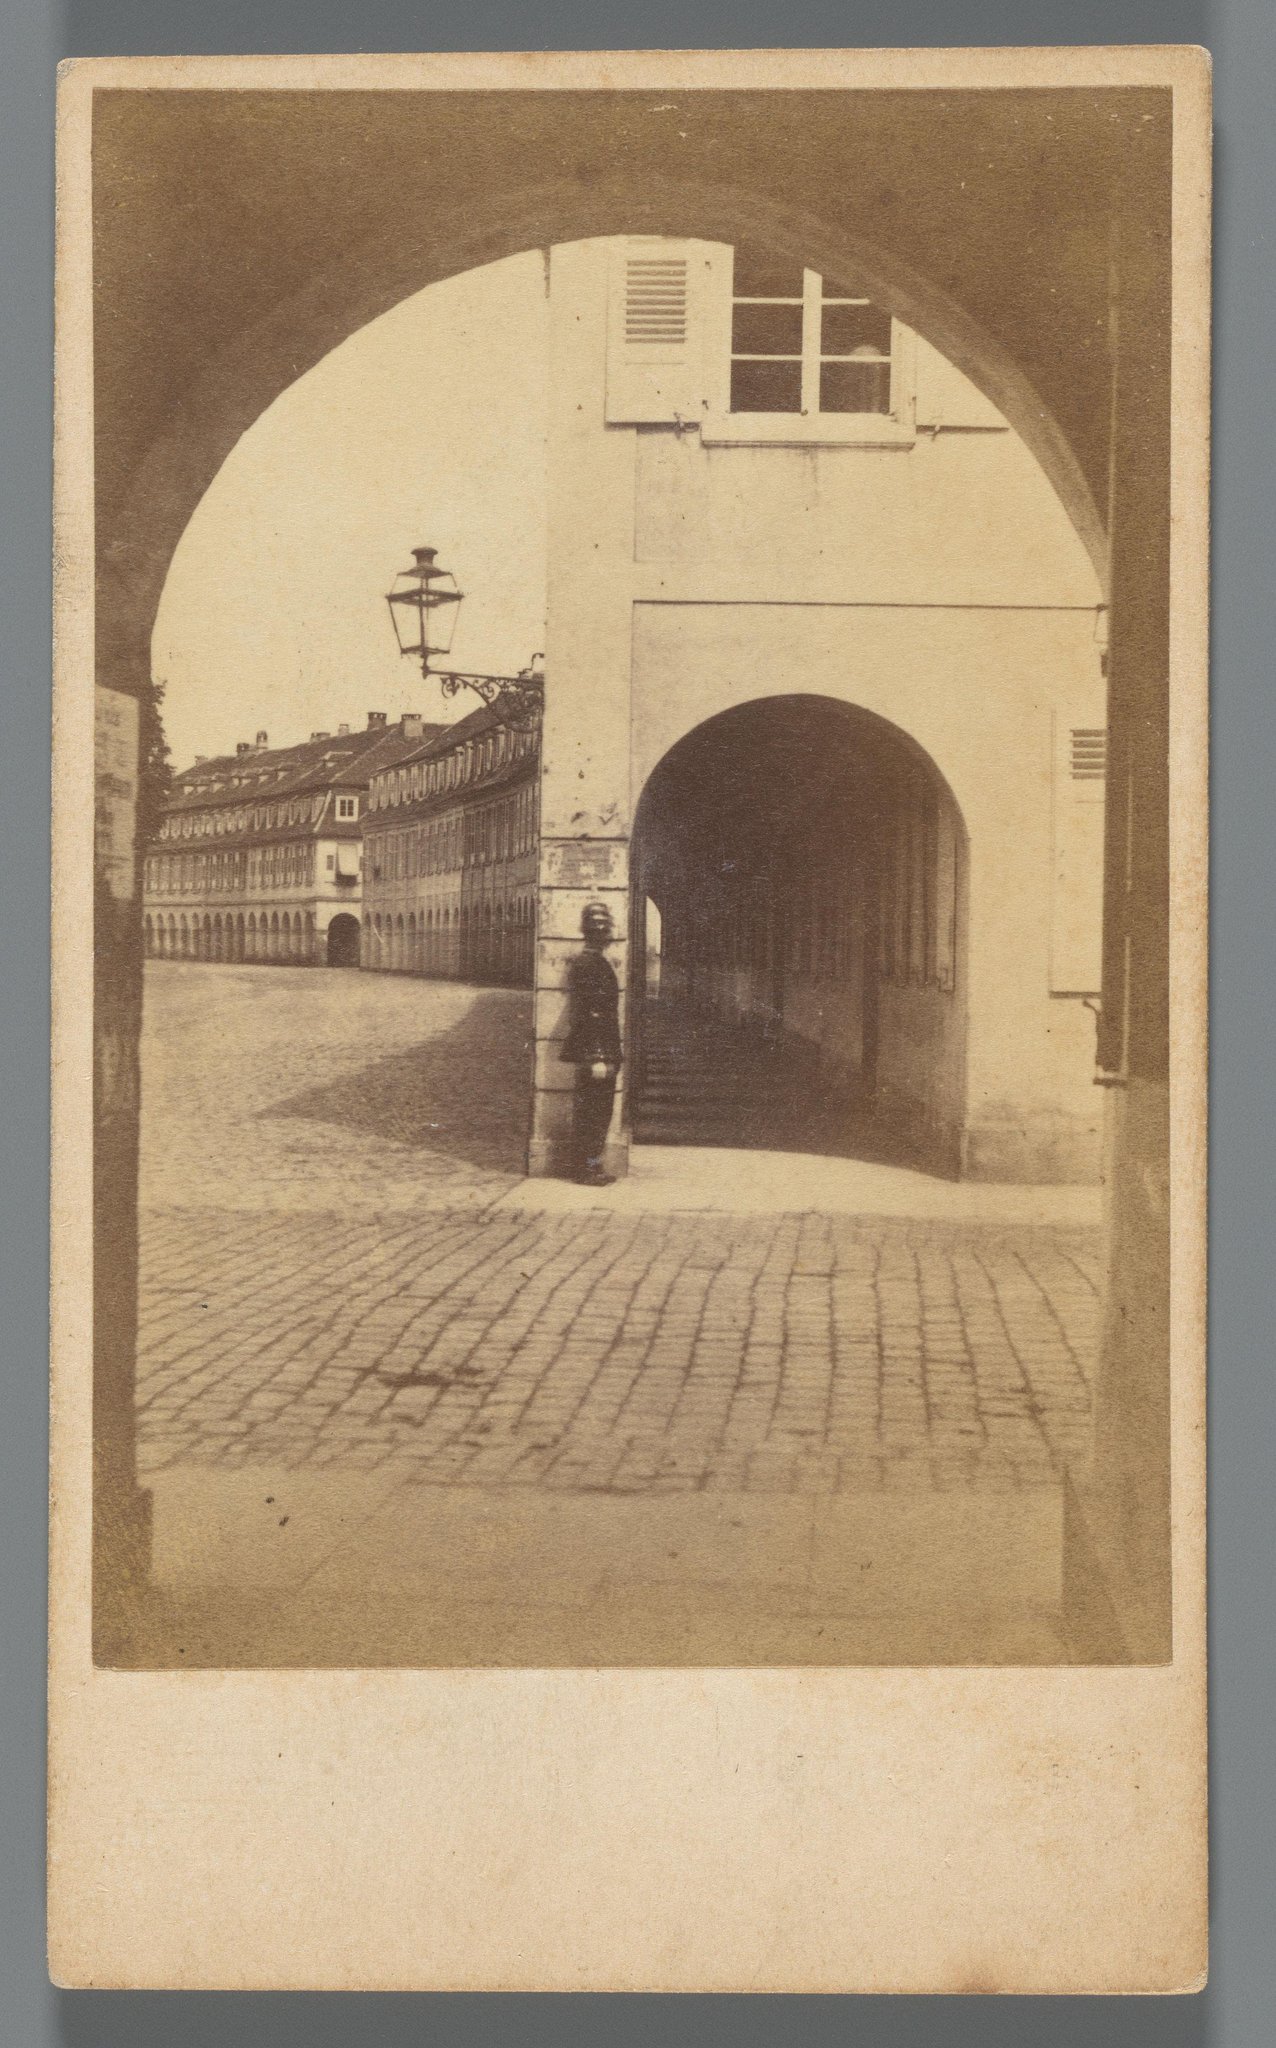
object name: carte de visite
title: Rue Circulaire, Karlsruhe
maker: Anonymous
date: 1860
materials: photographic support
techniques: albumen print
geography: karlsruhe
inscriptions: label: ‘N. 336 / CARLSRUHE (GRAND-DUCHÉ DE BADE) / Rue Circulaire, en face le Château. / Déposé / H.J.’